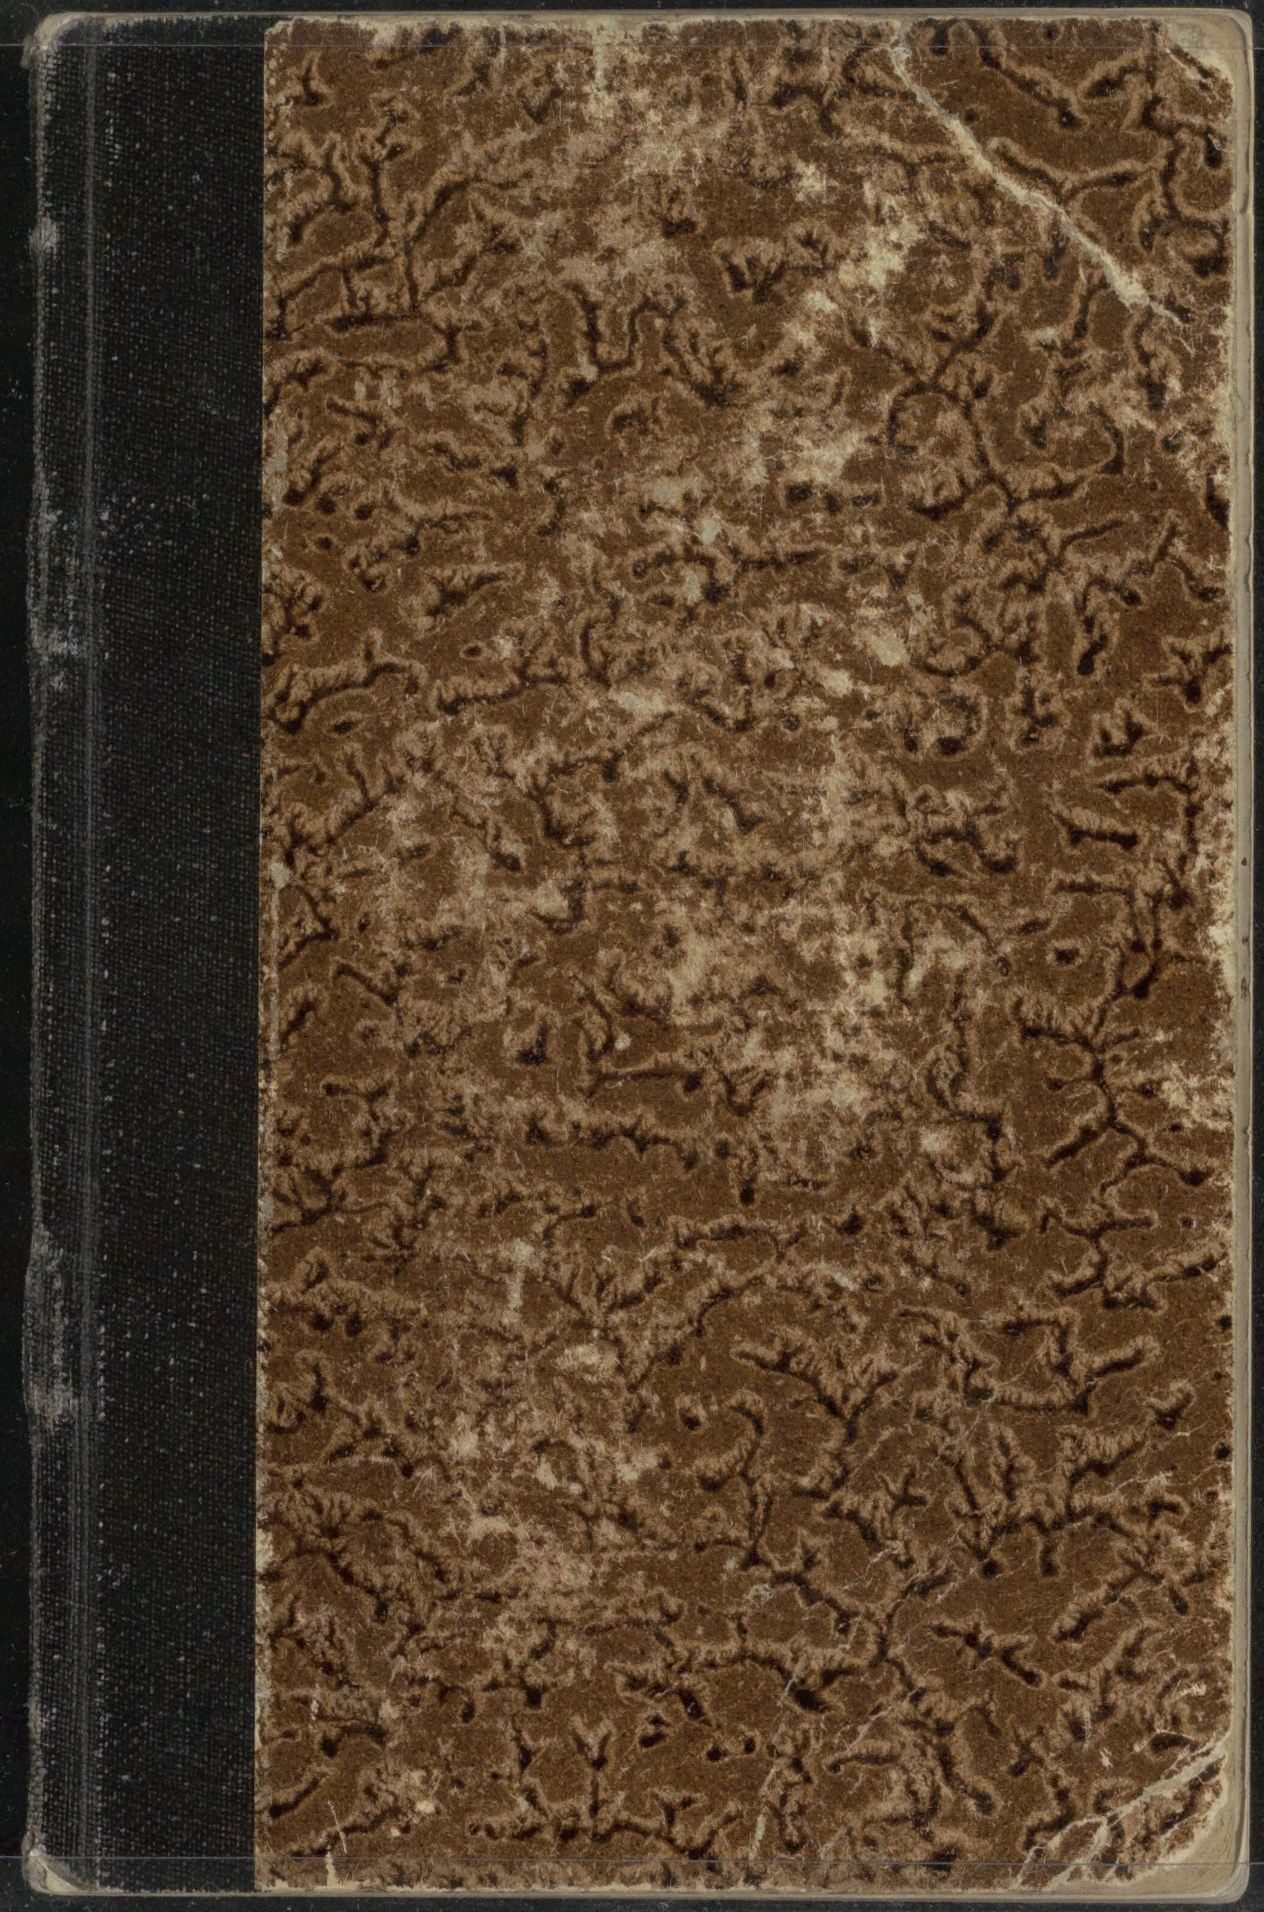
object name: sketchbook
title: Schetsboek met 39 bladen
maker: george hendrik breitner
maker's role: draughtsman, painter, print maker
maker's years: 1857-1923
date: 1900-1923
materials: cardboard, chalk, linen, paper, pencil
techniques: marbling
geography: rotterdam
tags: urban housing, adult woman, adult man, street, amsterdam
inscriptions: retailer's mark: ‘Gebrs. Simons/ Amsterdam./ Filiaal/ Heiligenweg 34/ Kantoorboek & Papierhandel./ Linieer- en Perforeer-inrichting./ No. 141 Blanco/ Bij nabestelling van dit boek, gelieve men/ bovenstaand nummer op te geven. / per doz f 1.60 per stuk 15’, annotation: ‘oude Hoogstraat/ Straatmakers Overtoom./ Noordermarkt/ Baan Rotterdam/ Rijtuig Dam/ Doorkijkje Overtoom/ Rokin uit de Bodega/ Dame aan de piano/ Rokin uit OZ. Kapelpoort/ oude huisjes. Rustenburgstraat/ Nieuwe Kerk./ Kar & paard/ Spui b/ Bagijnestraat/ Koopvrouw Rokin/ Nieuwe Kerk/ Kinderen op de tonnen Teertuinen/ Nieuwe Kerk/ oude huizen Spui/ Rijtuigje Damrak/ Straatje Nieuwendijk/ Munt plein/ Dam met Nieuwe Kerk/ oude huisjes Leidsche plein’, annotation: ‘Rotterdam’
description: Schetsboek bestaande uit 39 bladen met voornamelijk gezichten in Amsterdam en figuurstudies.